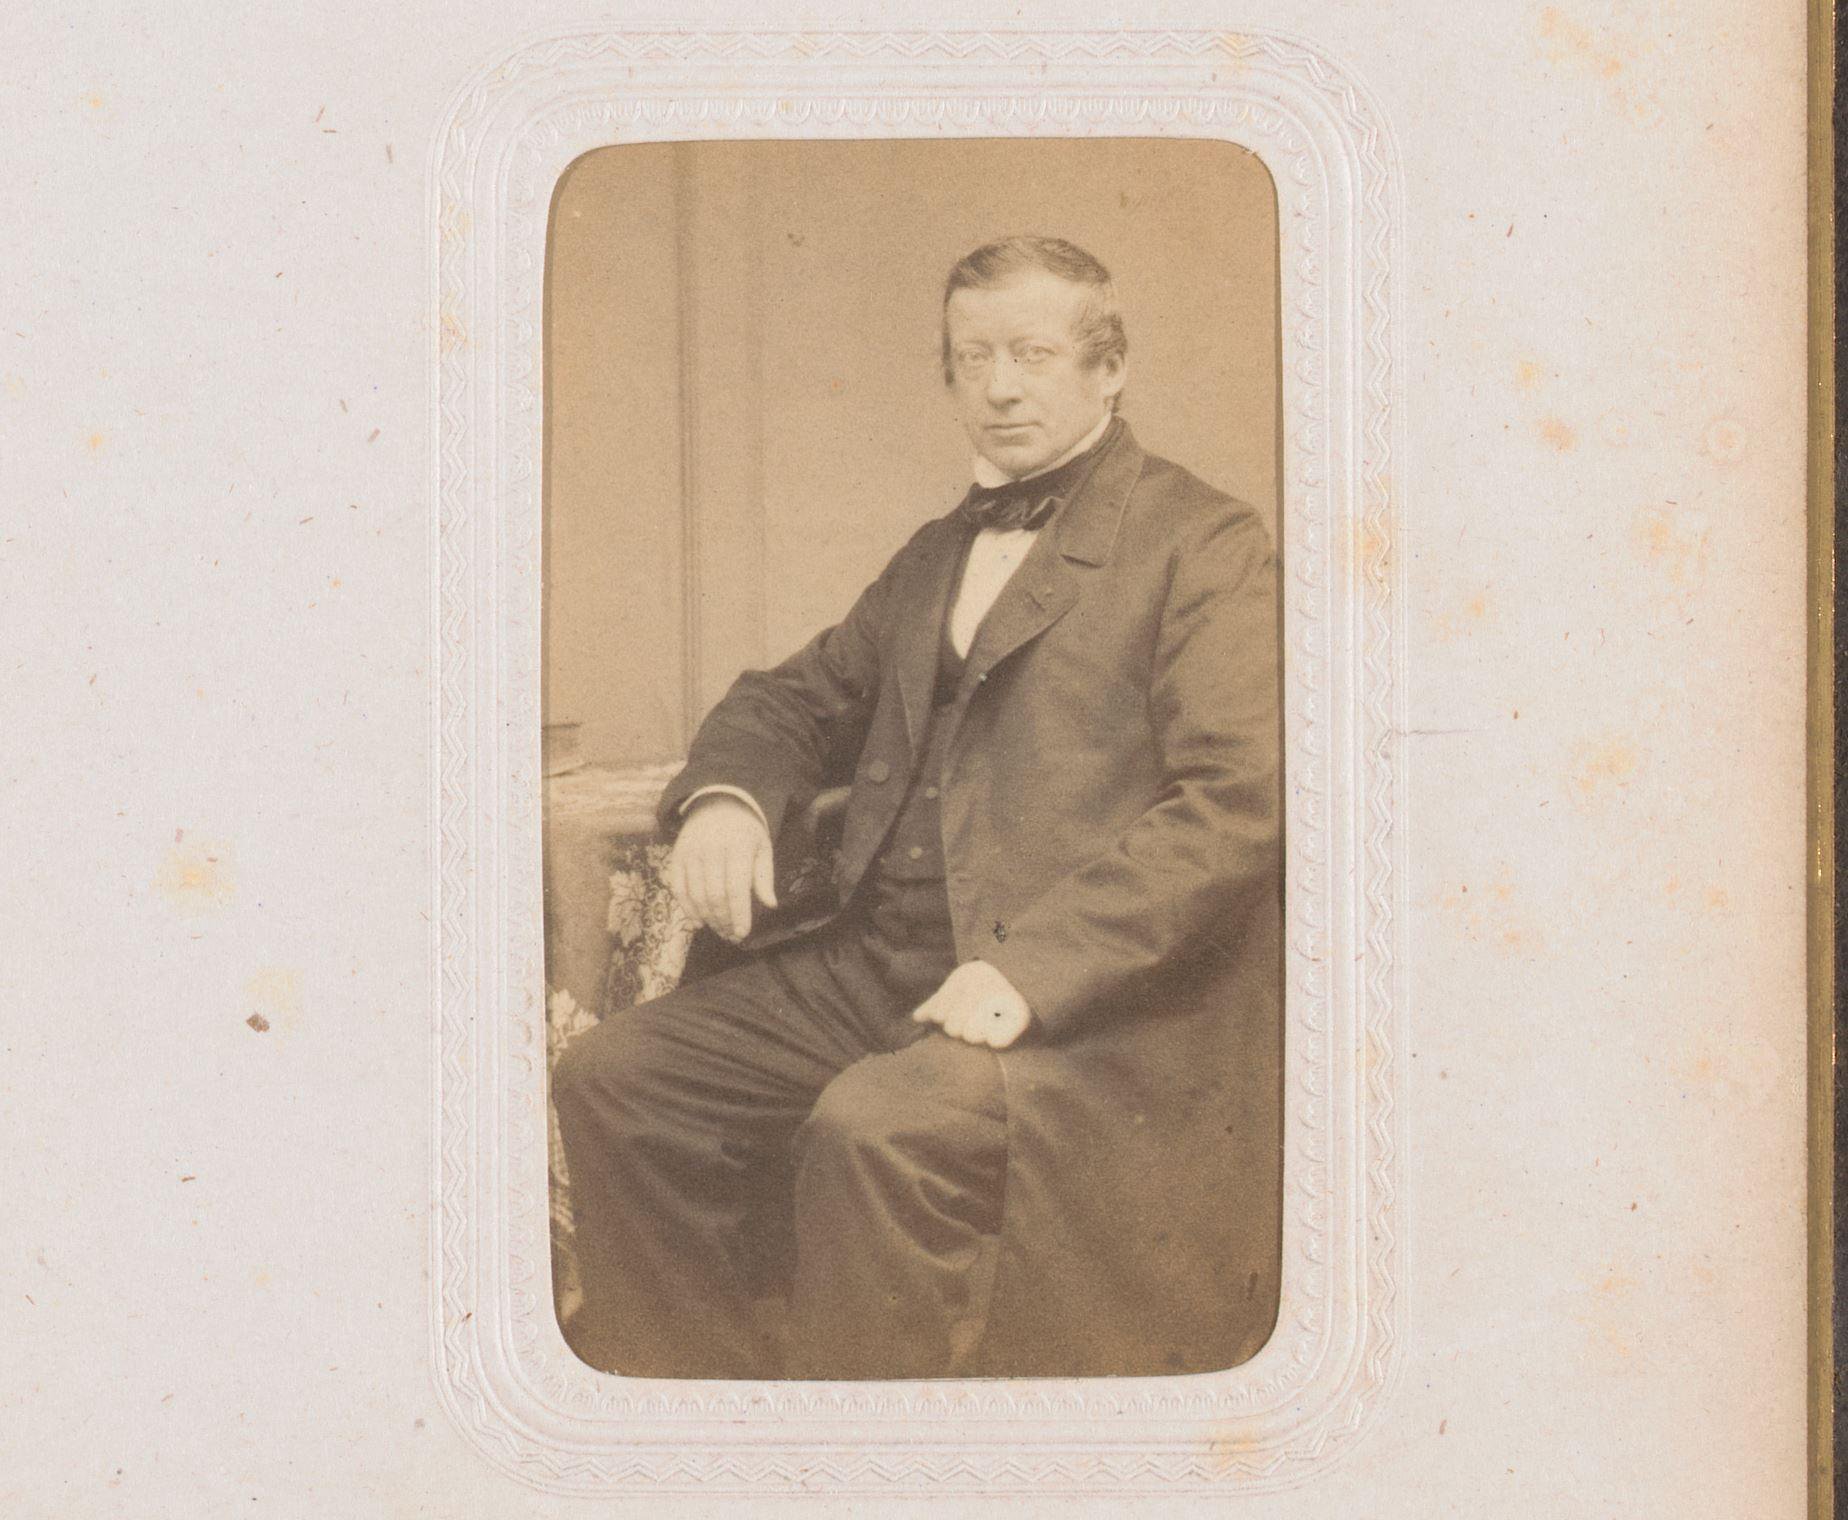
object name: album leaf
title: Portret van Cornelis Rudolphus Hermans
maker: leonard stollenwerk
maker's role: fotograaf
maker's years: 1829-1910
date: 1864-1883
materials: cardboard, photographic support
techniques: albumen print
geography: den bosch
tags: oss, den bosch, sitting figure, historical persons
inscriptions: name: ‘Hermans’, name: ‘Hermans’, inscription: ‘PHOTOGRAPHIE/ VAN/ L. STOLLENWERK/ SPIEGEL en LIJSTENFABRIEK/ 's BOSCH./ ZILVEREN MEDAILLE/ EERSTE/ PROVINCIALE/ TENTOONSTELLING/ VAN/ NYVERHEID/ 'S HERTOGENBOSCH/ 1857.’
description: Portret van Cornelis Rudolphus Hermans, geschiedkundige, oudheidkundig en letterkundige.